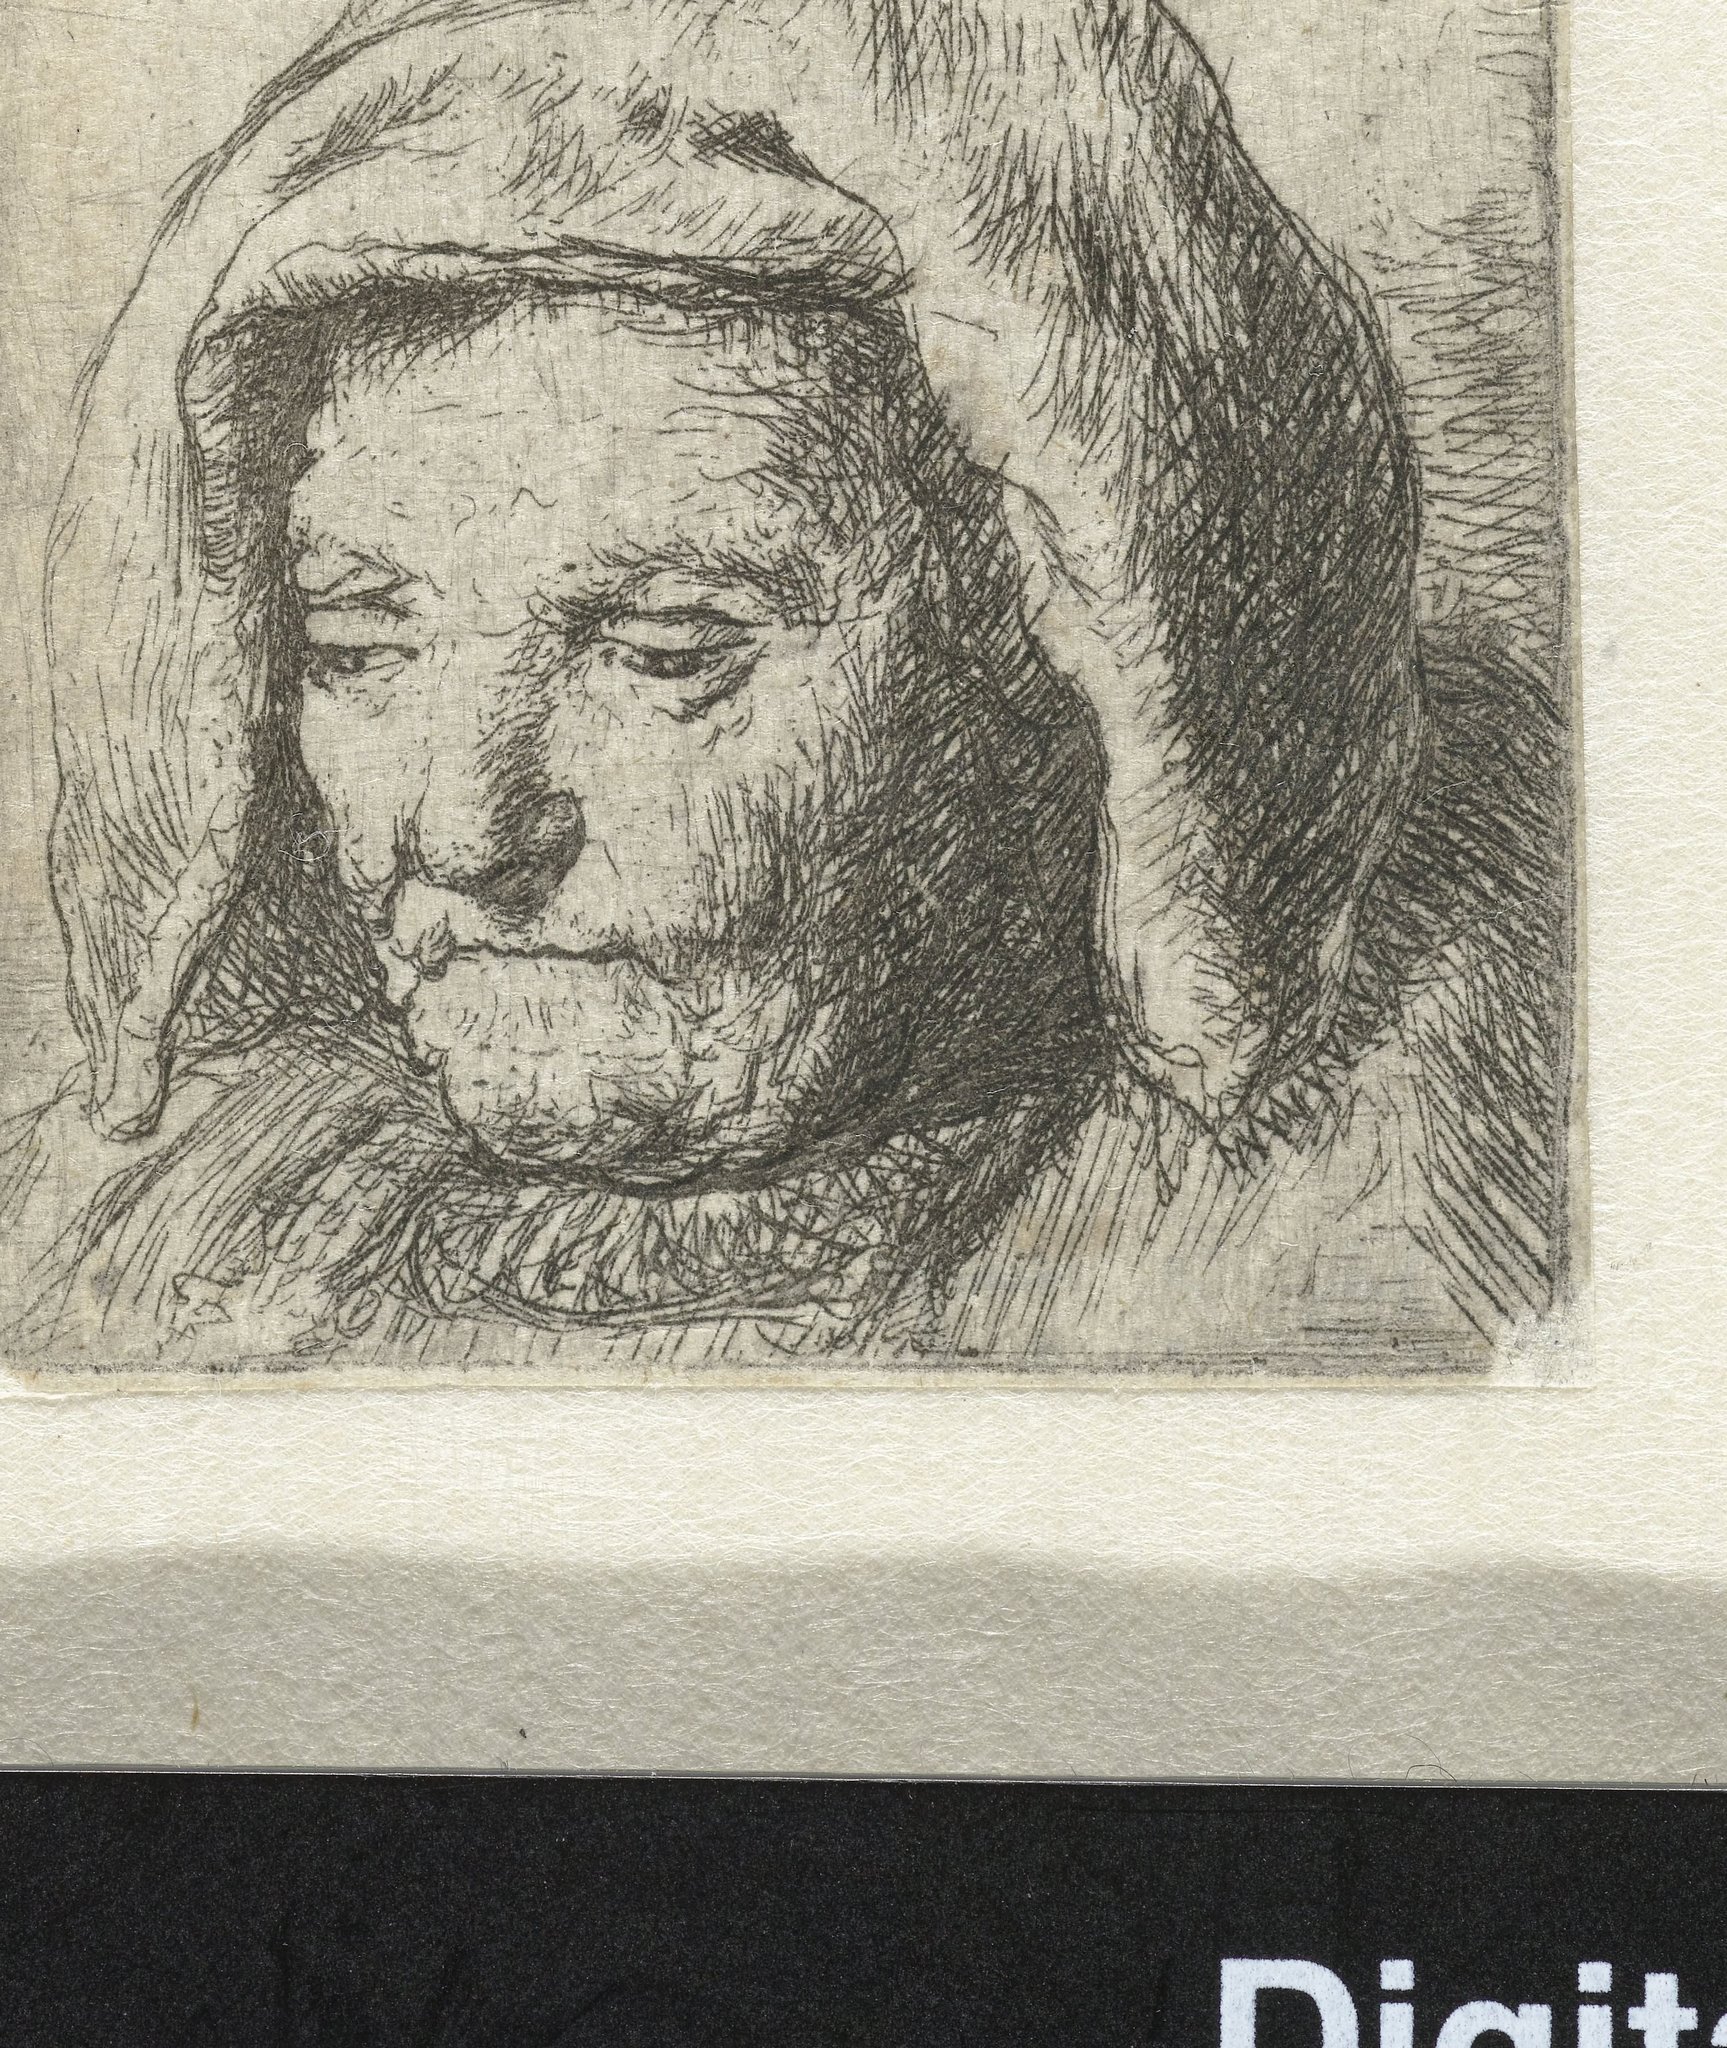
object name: print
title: The artist's mother in a cloth headdress, looking down: head only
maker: Anonymous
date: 1633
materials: paper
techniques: etching, intaglio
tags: historical persons - bb - woman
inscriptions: collector's mark: Lugt 240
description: Spiegelbeeldige kopie naar de gelijknamige prent van Rembrandt.